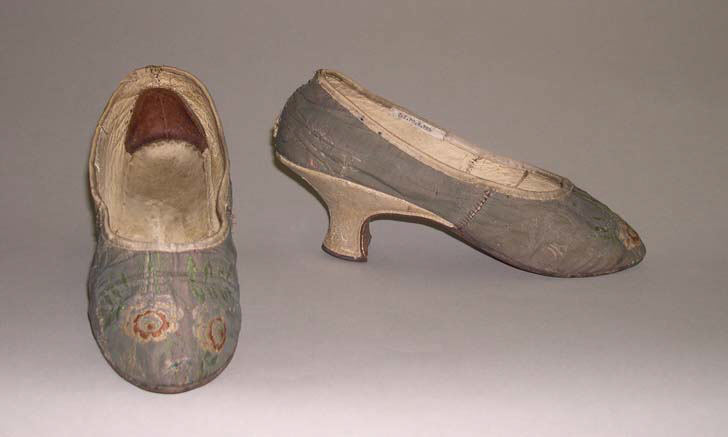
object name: shoe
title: Shoes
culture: european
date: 1770-1789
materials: silk